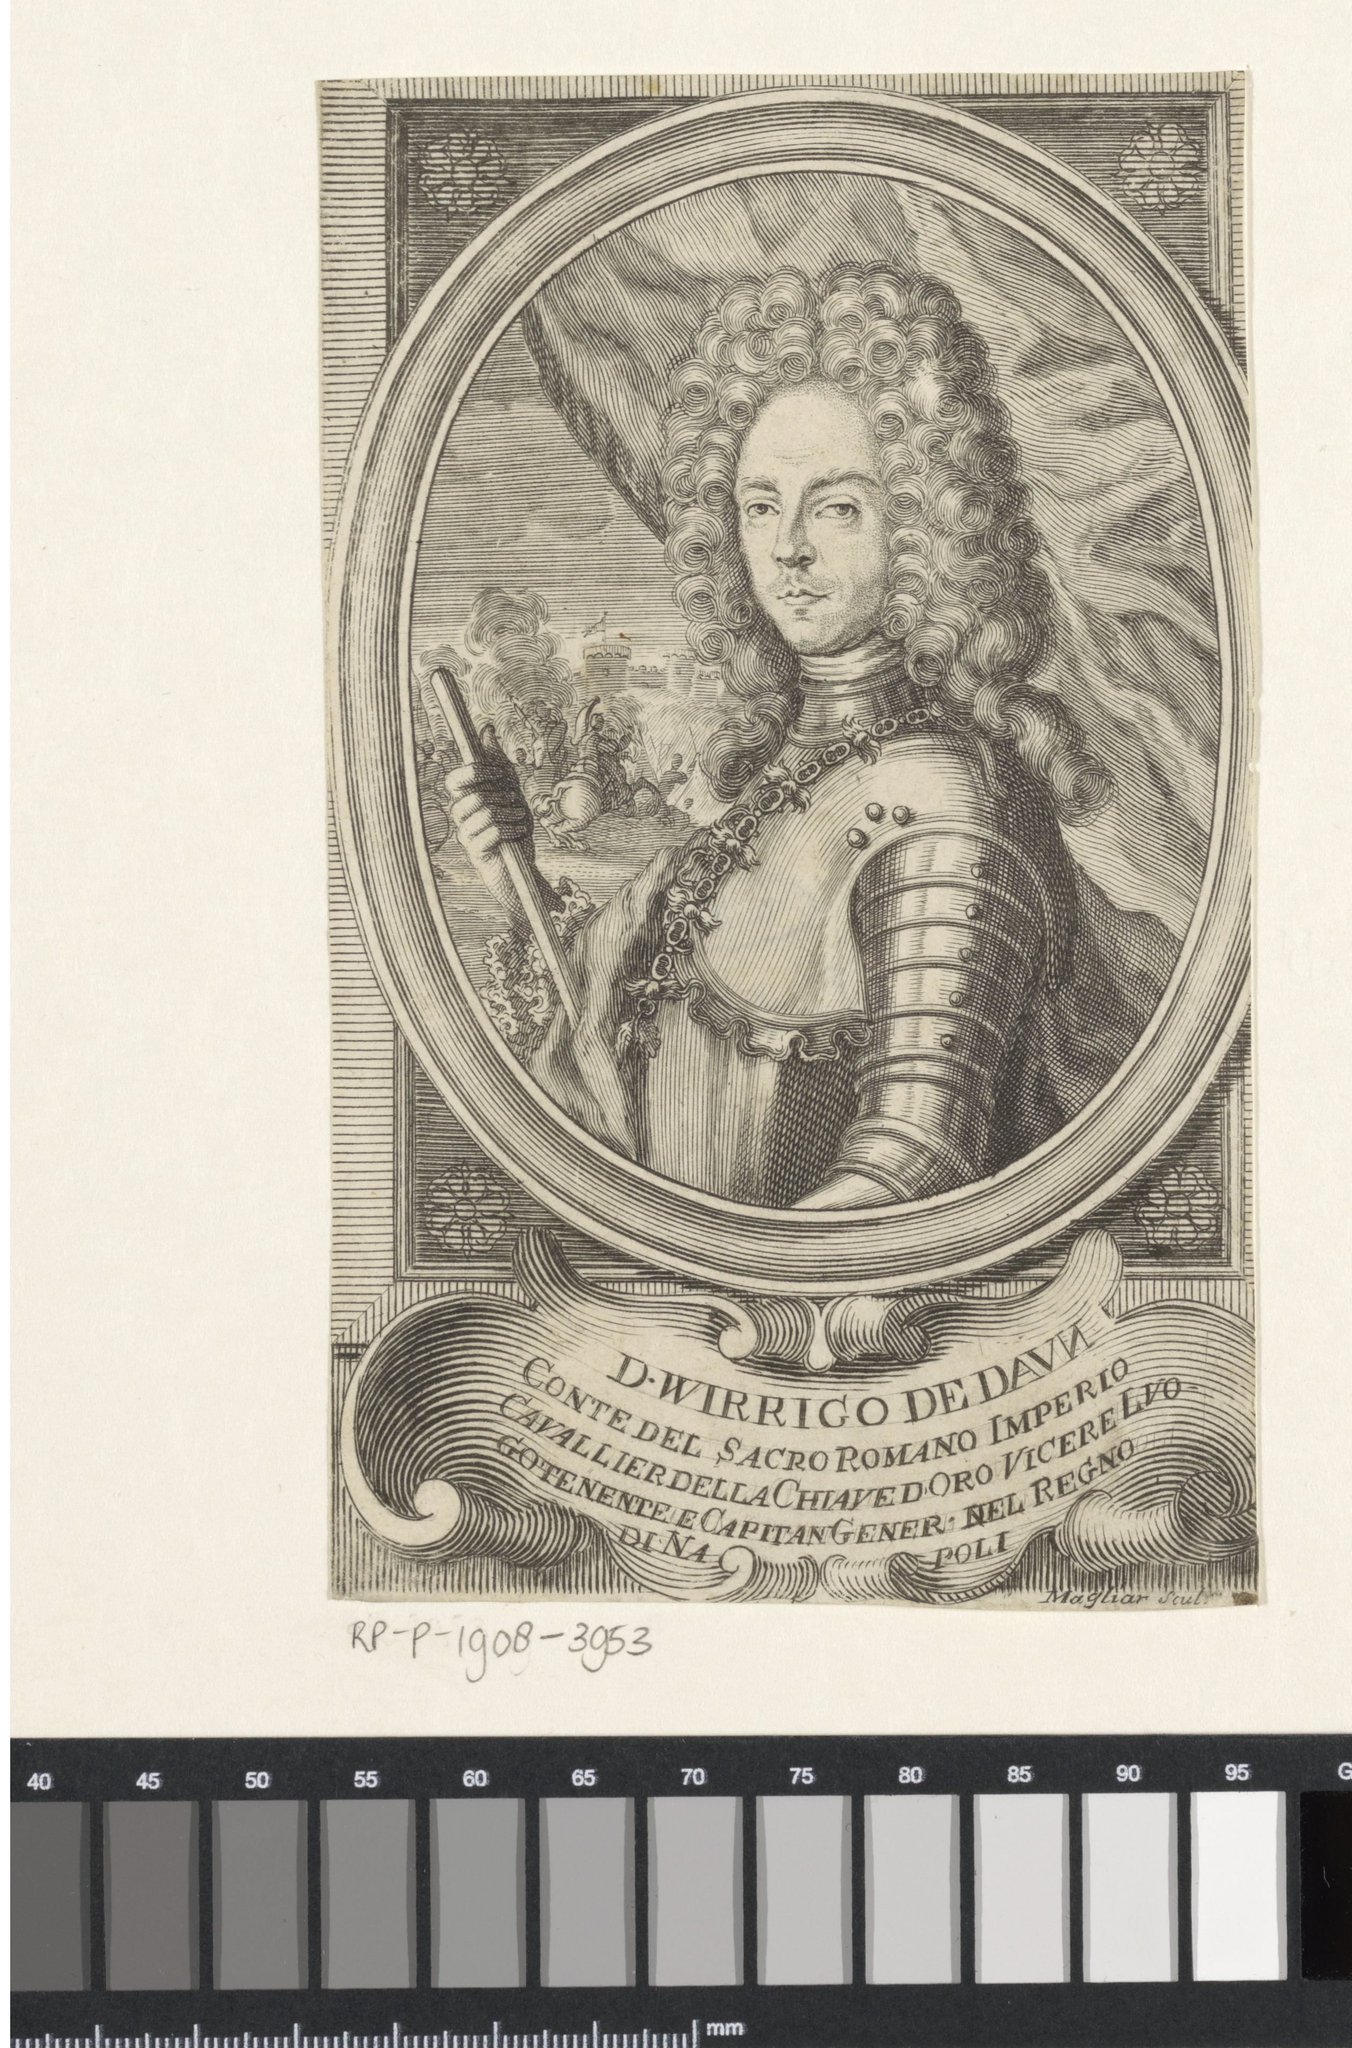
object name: print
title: Portret van D. Wirrigo de Daun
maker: andrea magliar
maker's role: draughtsman, print maker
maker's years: 1690-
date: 1700-1799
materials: paper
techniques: engraving, etching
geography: italy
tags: historical persons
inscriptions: collector's mark: Lugt 2228